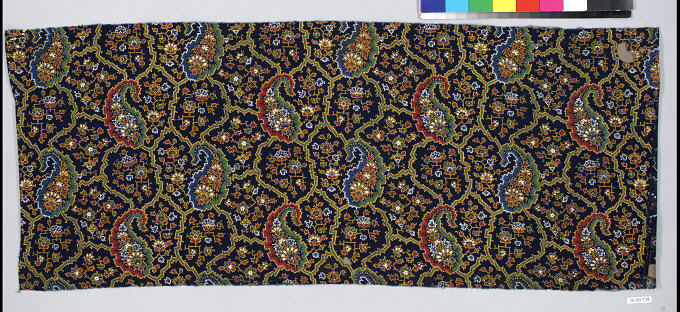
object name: piece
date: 1867-1900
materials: cotton